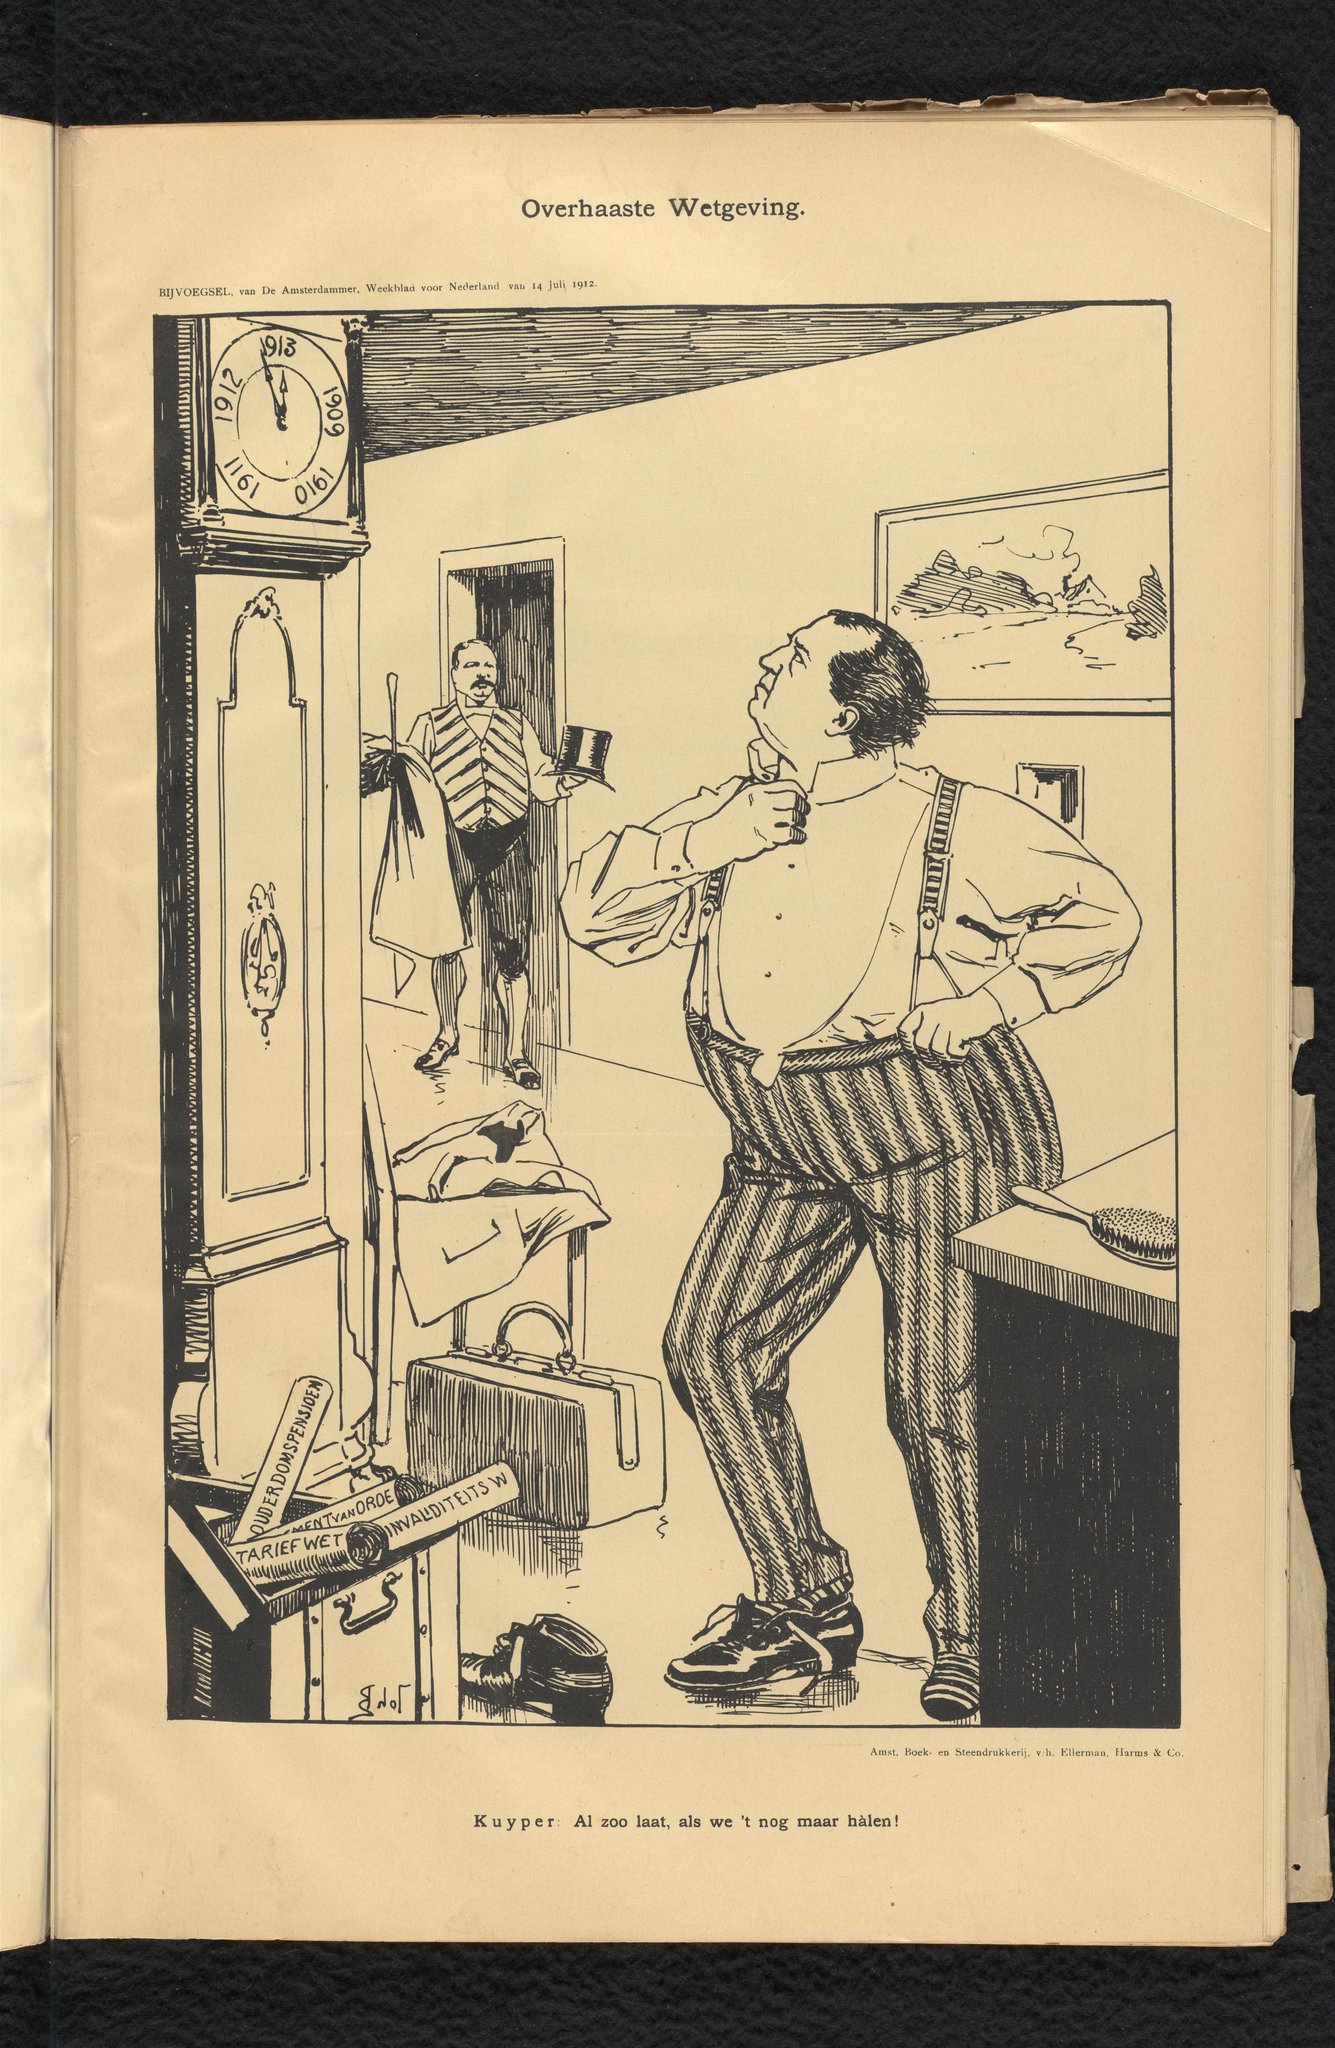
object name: cartoon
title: Overhaaste Wetgeving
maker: johan braakensiek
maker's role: draughtsman, print maker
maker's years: 1858-1940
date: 1912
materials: paper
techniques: lithograph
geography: netherlands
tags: the hague, abraham kuyper, legislation, dressing oneself, getting dressed, political caricatures and satires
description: Abraham Kuyper als een heer die laat is met zich aankleden. Hij kijkt naar de klok waarvan de wijzers bijna op 1913 staan. Uit de reiskoffer steken de wetten die hij nog wil indienen.